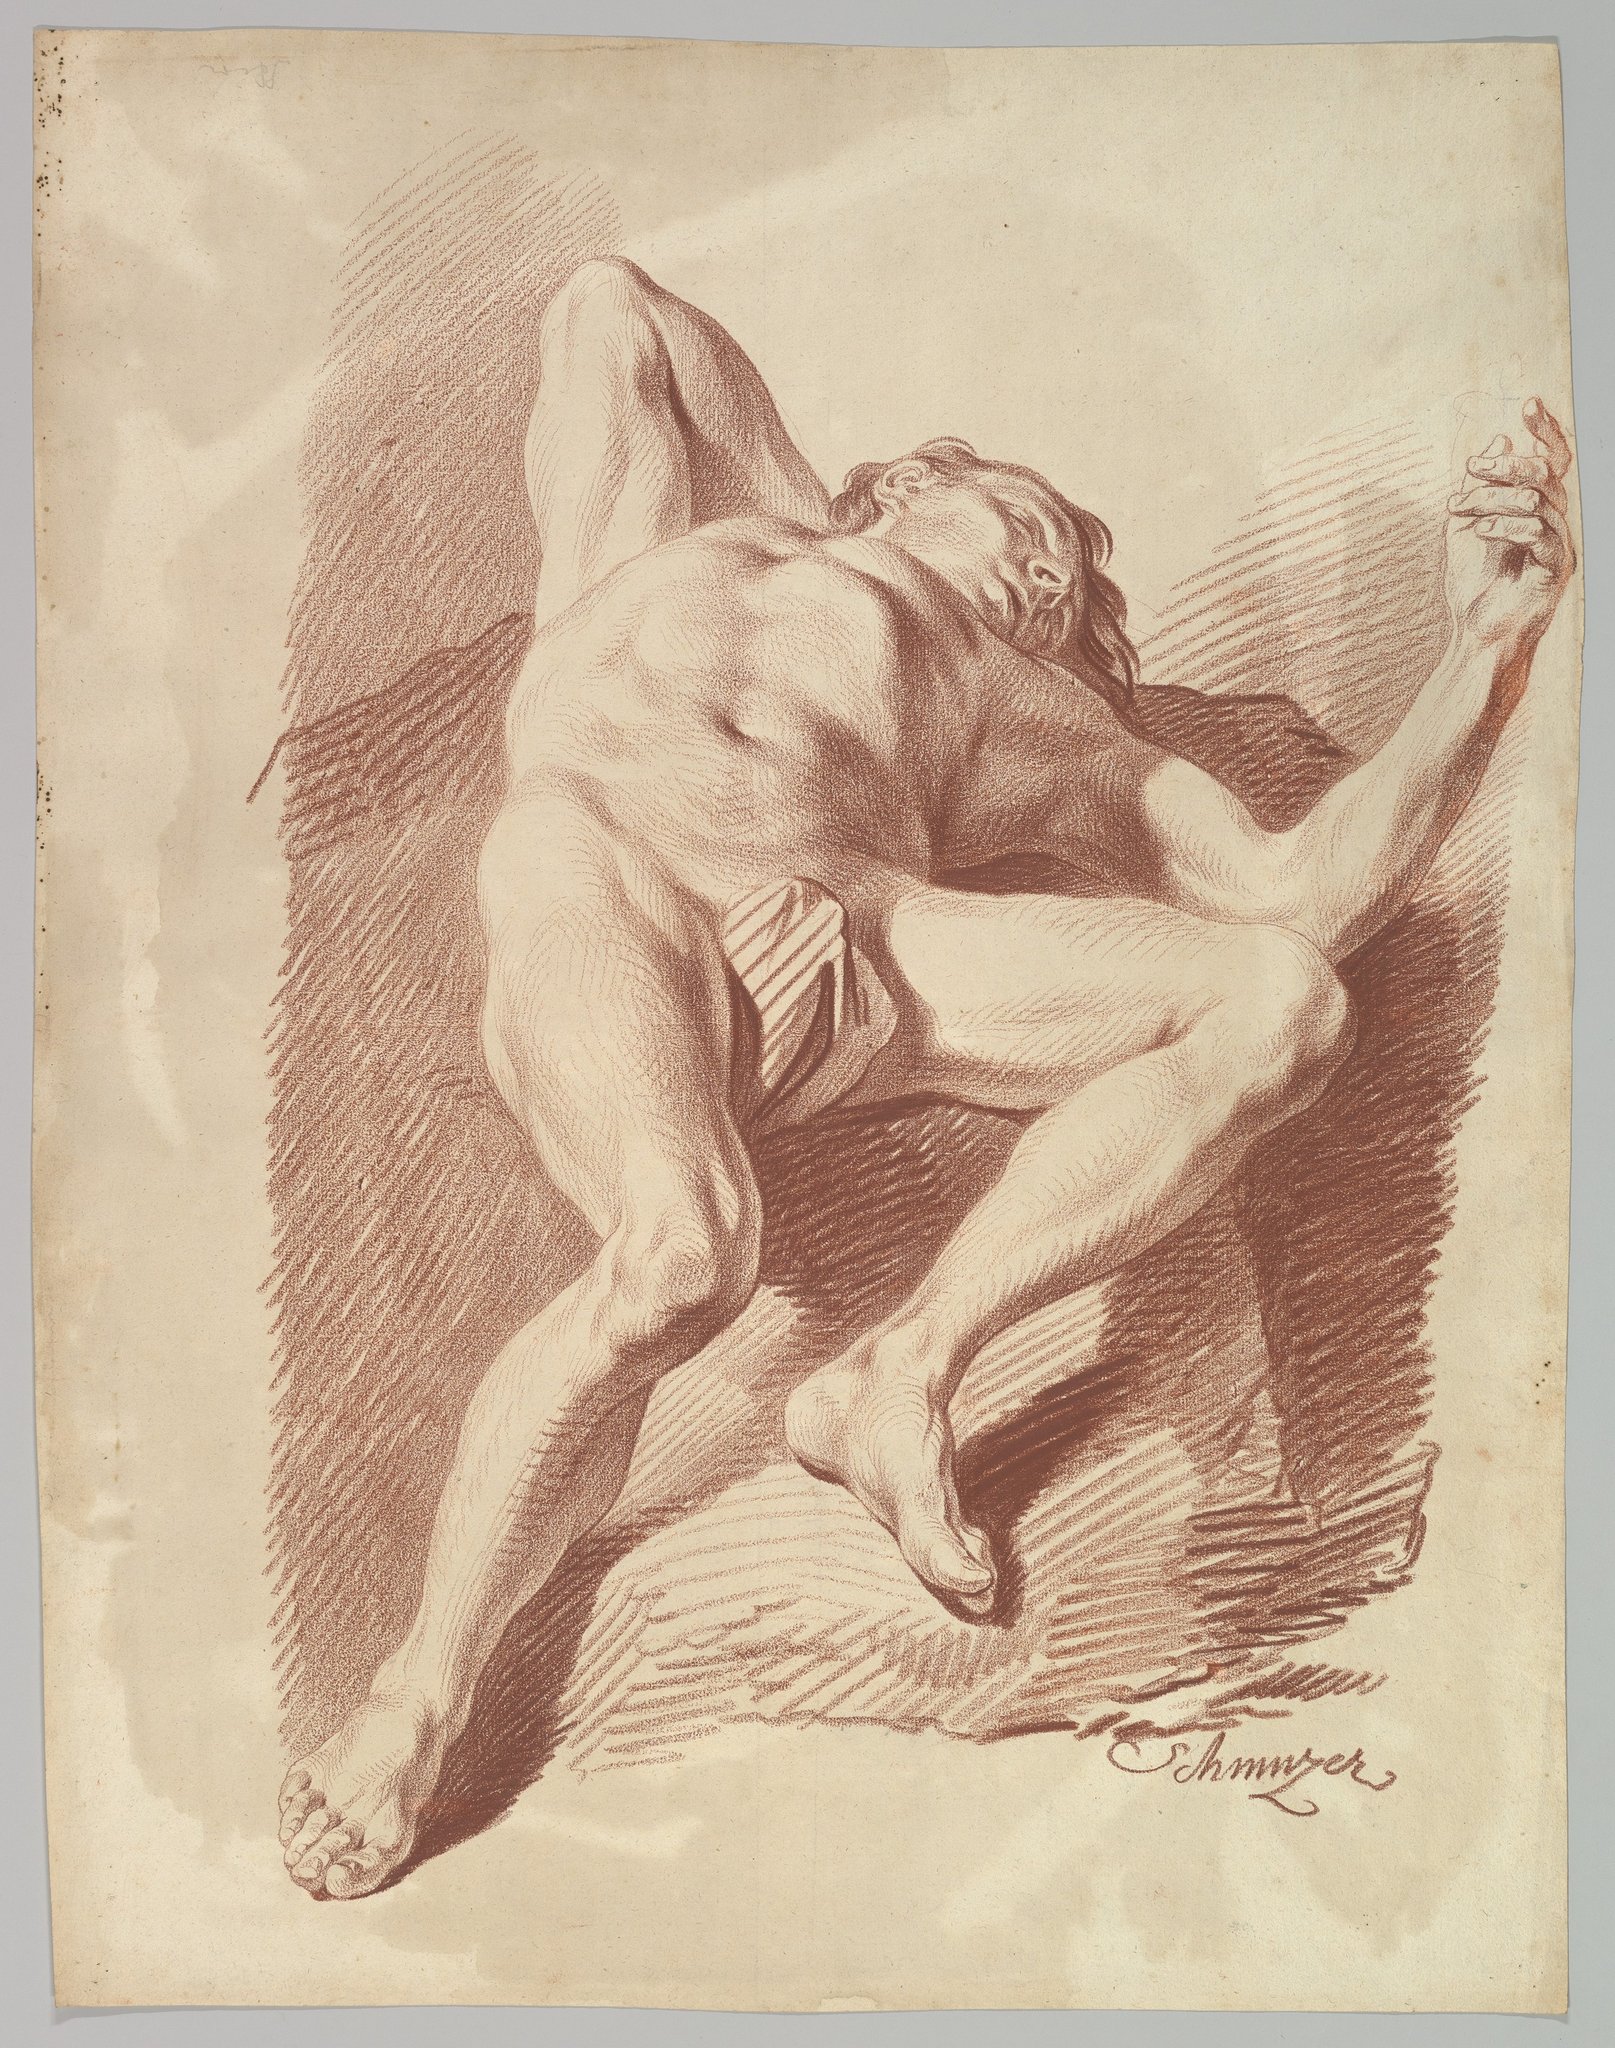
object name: drawing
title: Reclining Male Nude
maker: jakob matthias schmutzer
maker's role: artist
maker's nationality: austrian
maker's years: 1733-1811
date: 1765-1810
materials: chalk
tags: male nudes